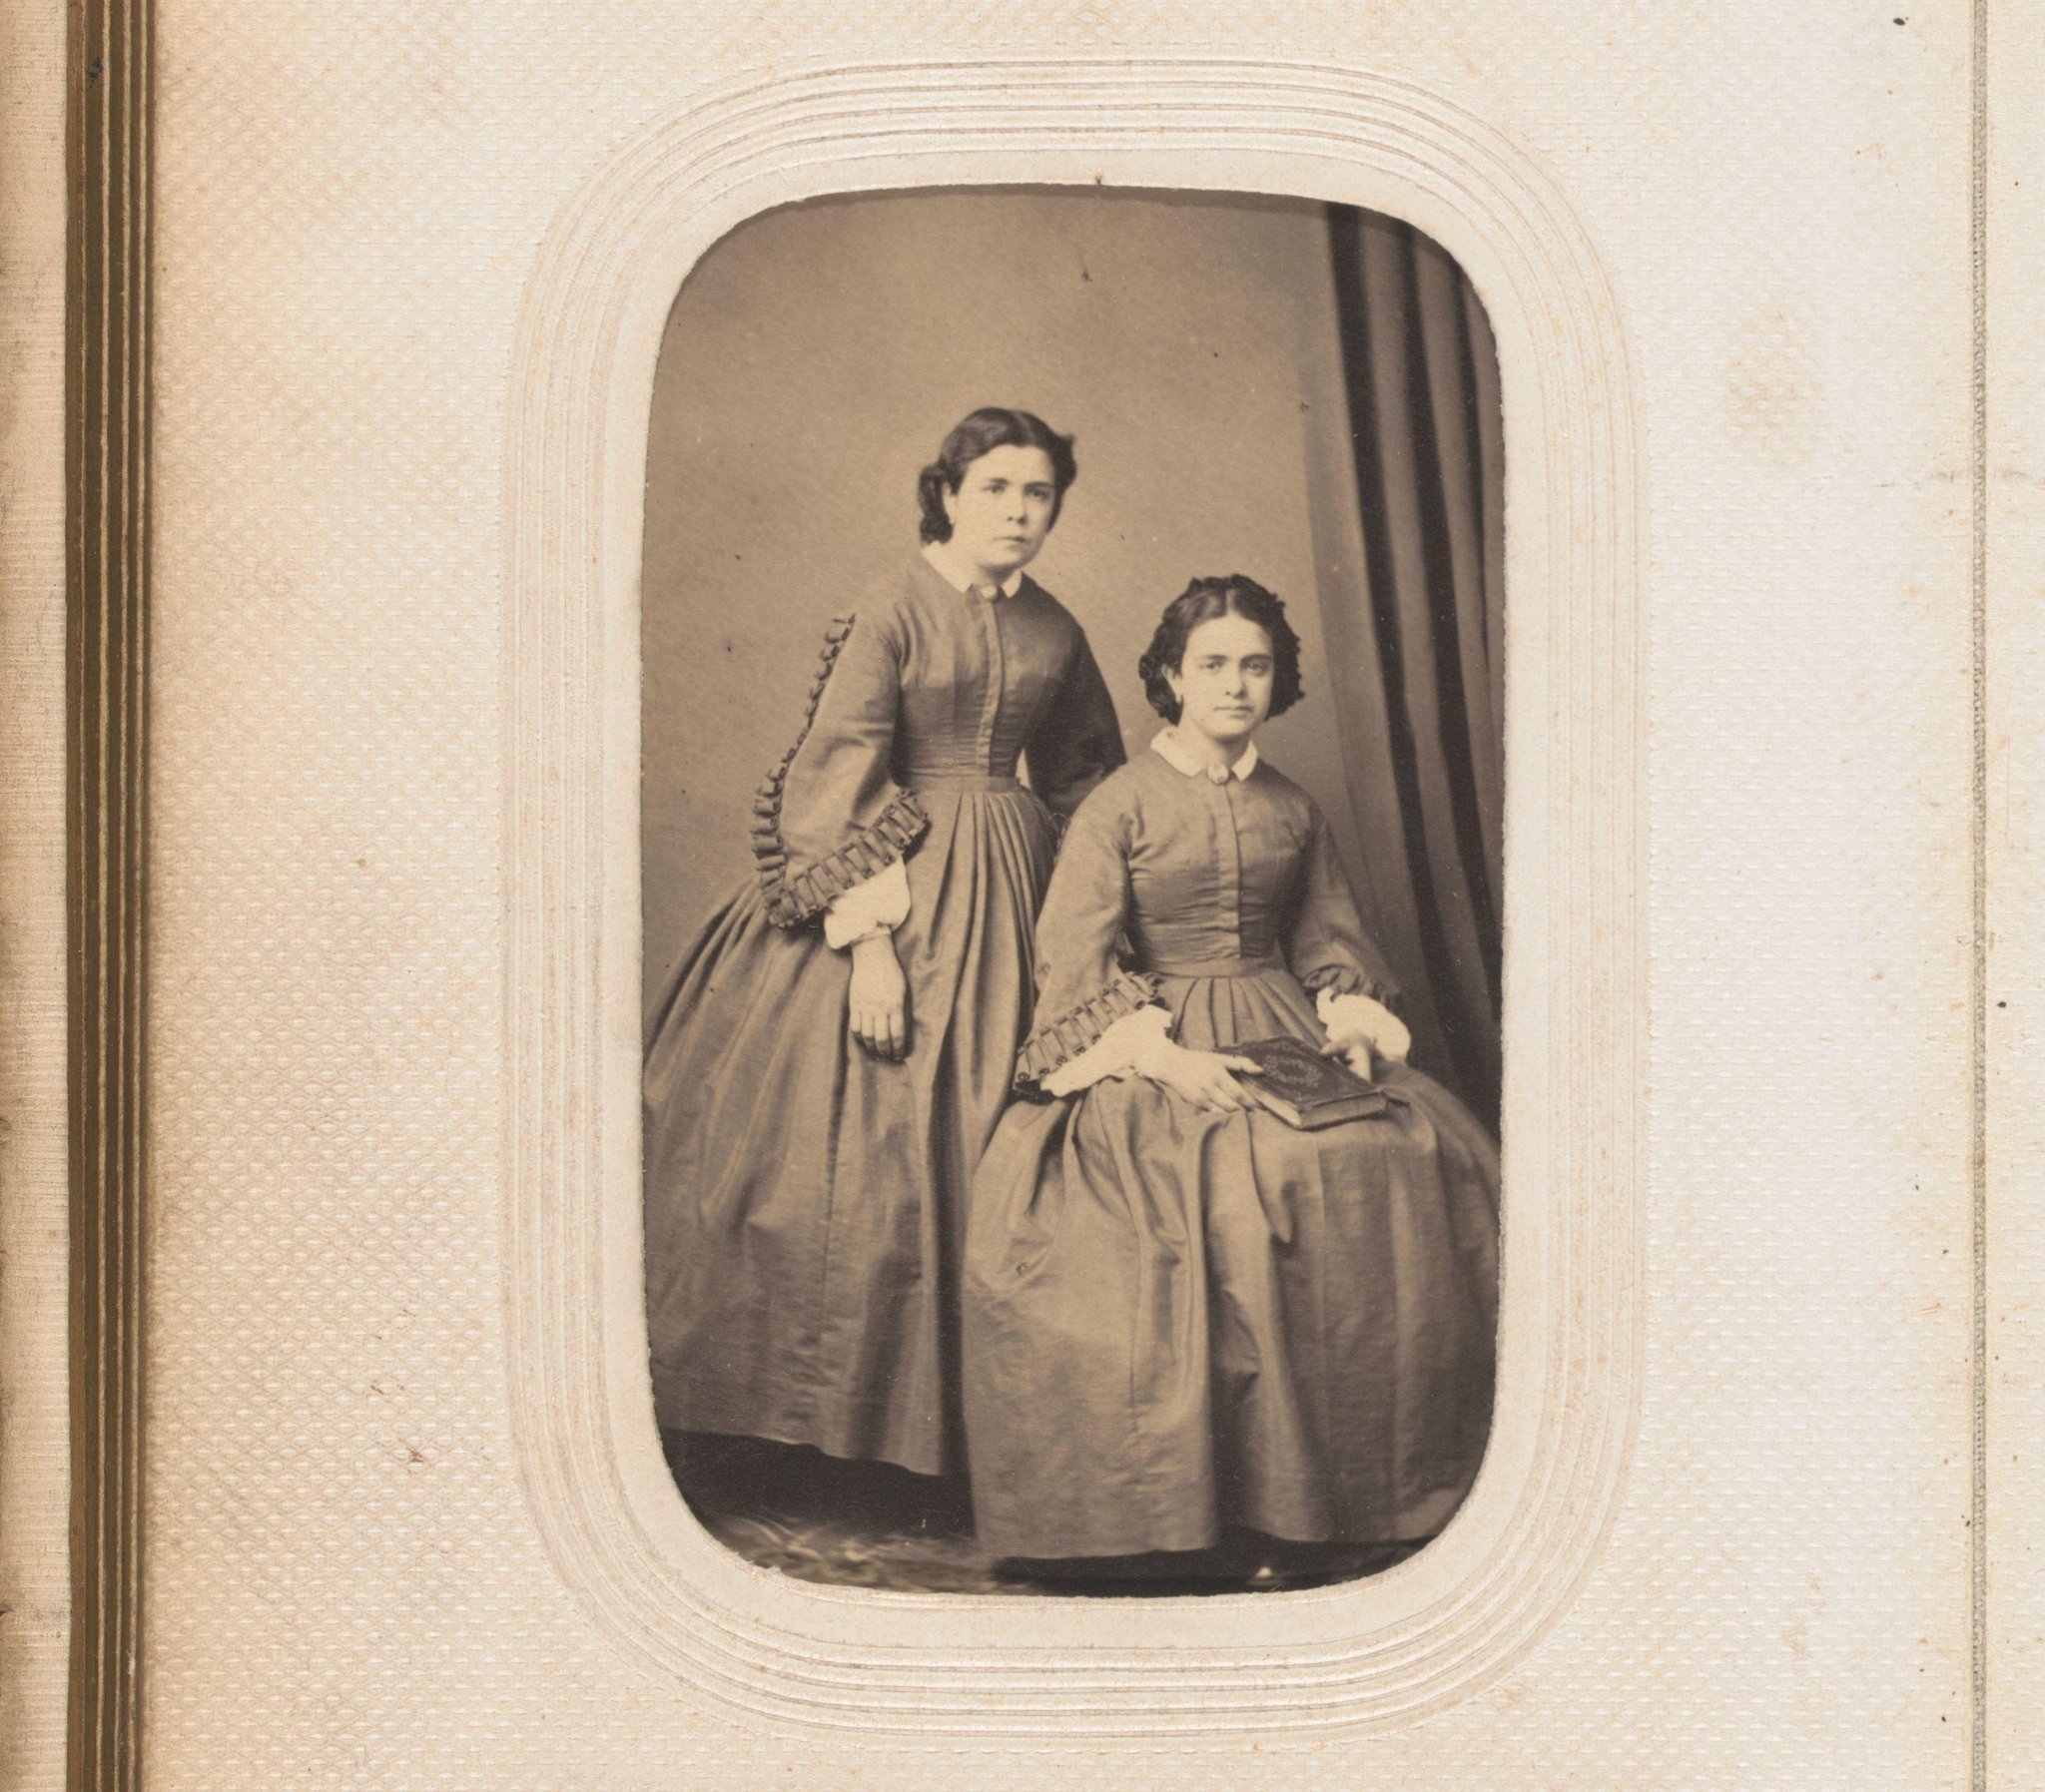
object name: photograph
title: Portret van een twee meisjes, een zittend met een boek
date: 1855-1865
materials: cardboard, photographic support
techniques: albumen print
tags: adolescent, young woman, maiden, historical persons, girl (child between toddler and youth), book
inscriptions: inscription: ‘Photographie/ Charles/ 3 Rue Mautrec/ Bordeaux’